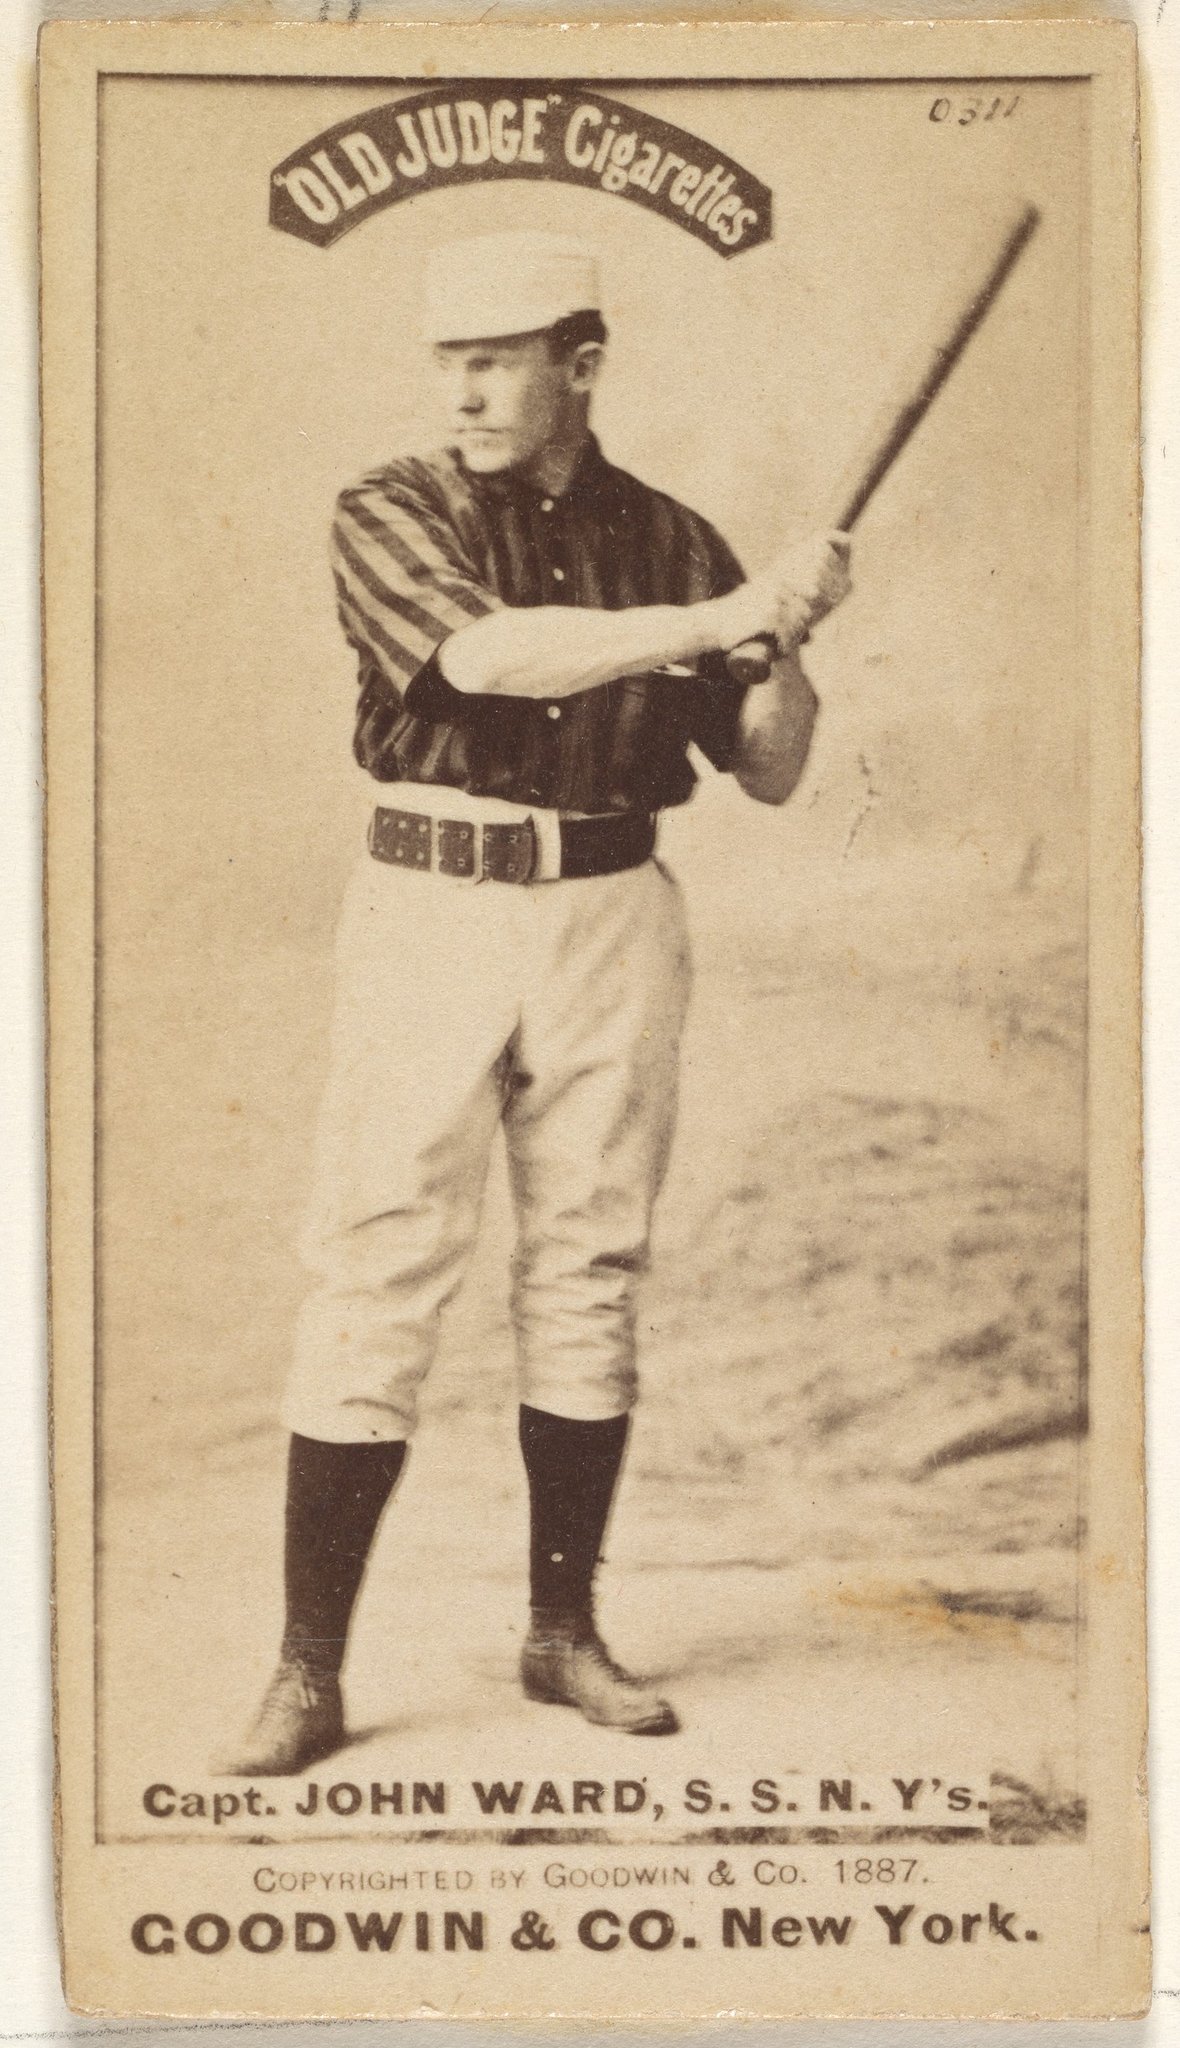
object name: baseball card, photograph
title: John Montgomery Ward, Captain and Shortstop, New York, from the Old Judge series (N172) for Old Judge Cigarettes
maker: goodwin & company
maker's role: publisher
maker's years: 1850-1950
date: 1887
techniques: albumen silver print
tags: men,portraits,baseball,athletes